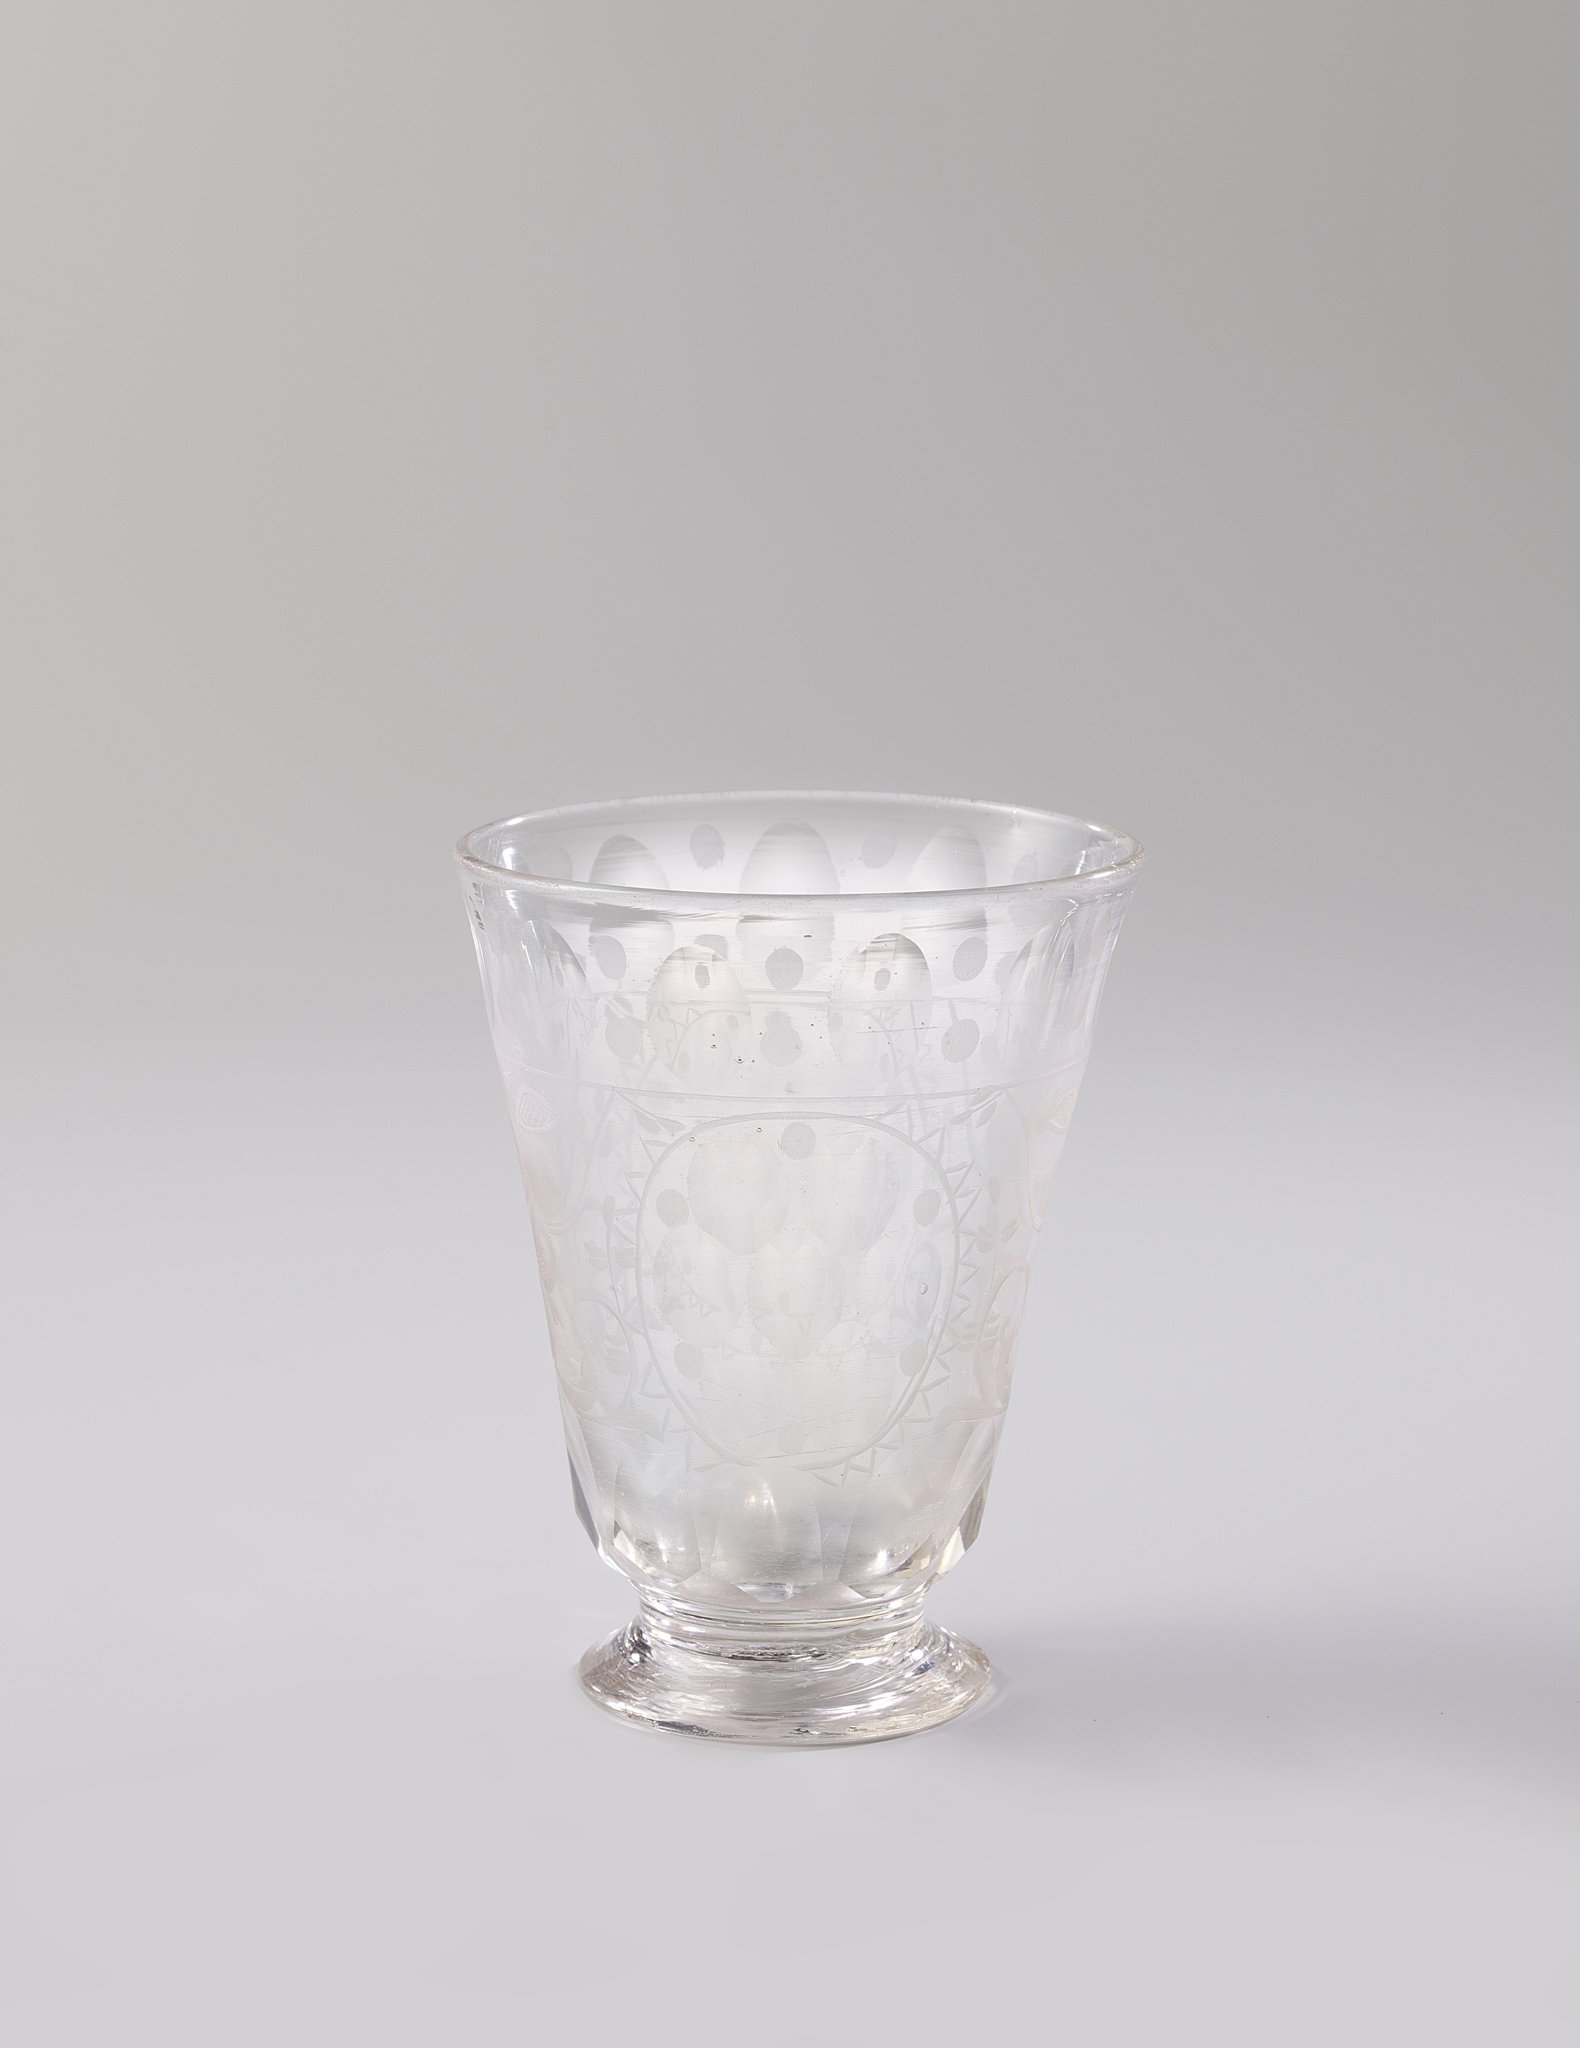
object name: standing cup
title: Beker op voet met trossen bestaande uit rozetten en cirkels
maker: Anonymous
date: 1750-1800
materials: glass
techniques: glassblowing, grinding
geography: bohemia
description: Conische voet. Het uitlopende lichaam is aan de onderzijde facetgeslepen. Op het lichaam, tussen twee doorlopende gematteerde lijnen en een band met gegraveerde cirkels en gematteerde punten langs de rand, loopt een brede band met twee rozetten van gegraveerde cirkels, elk in een medaillon omgeven door een zigzaglijn, van elkaar gescheiden door twee bloemguirlandes met bessen.